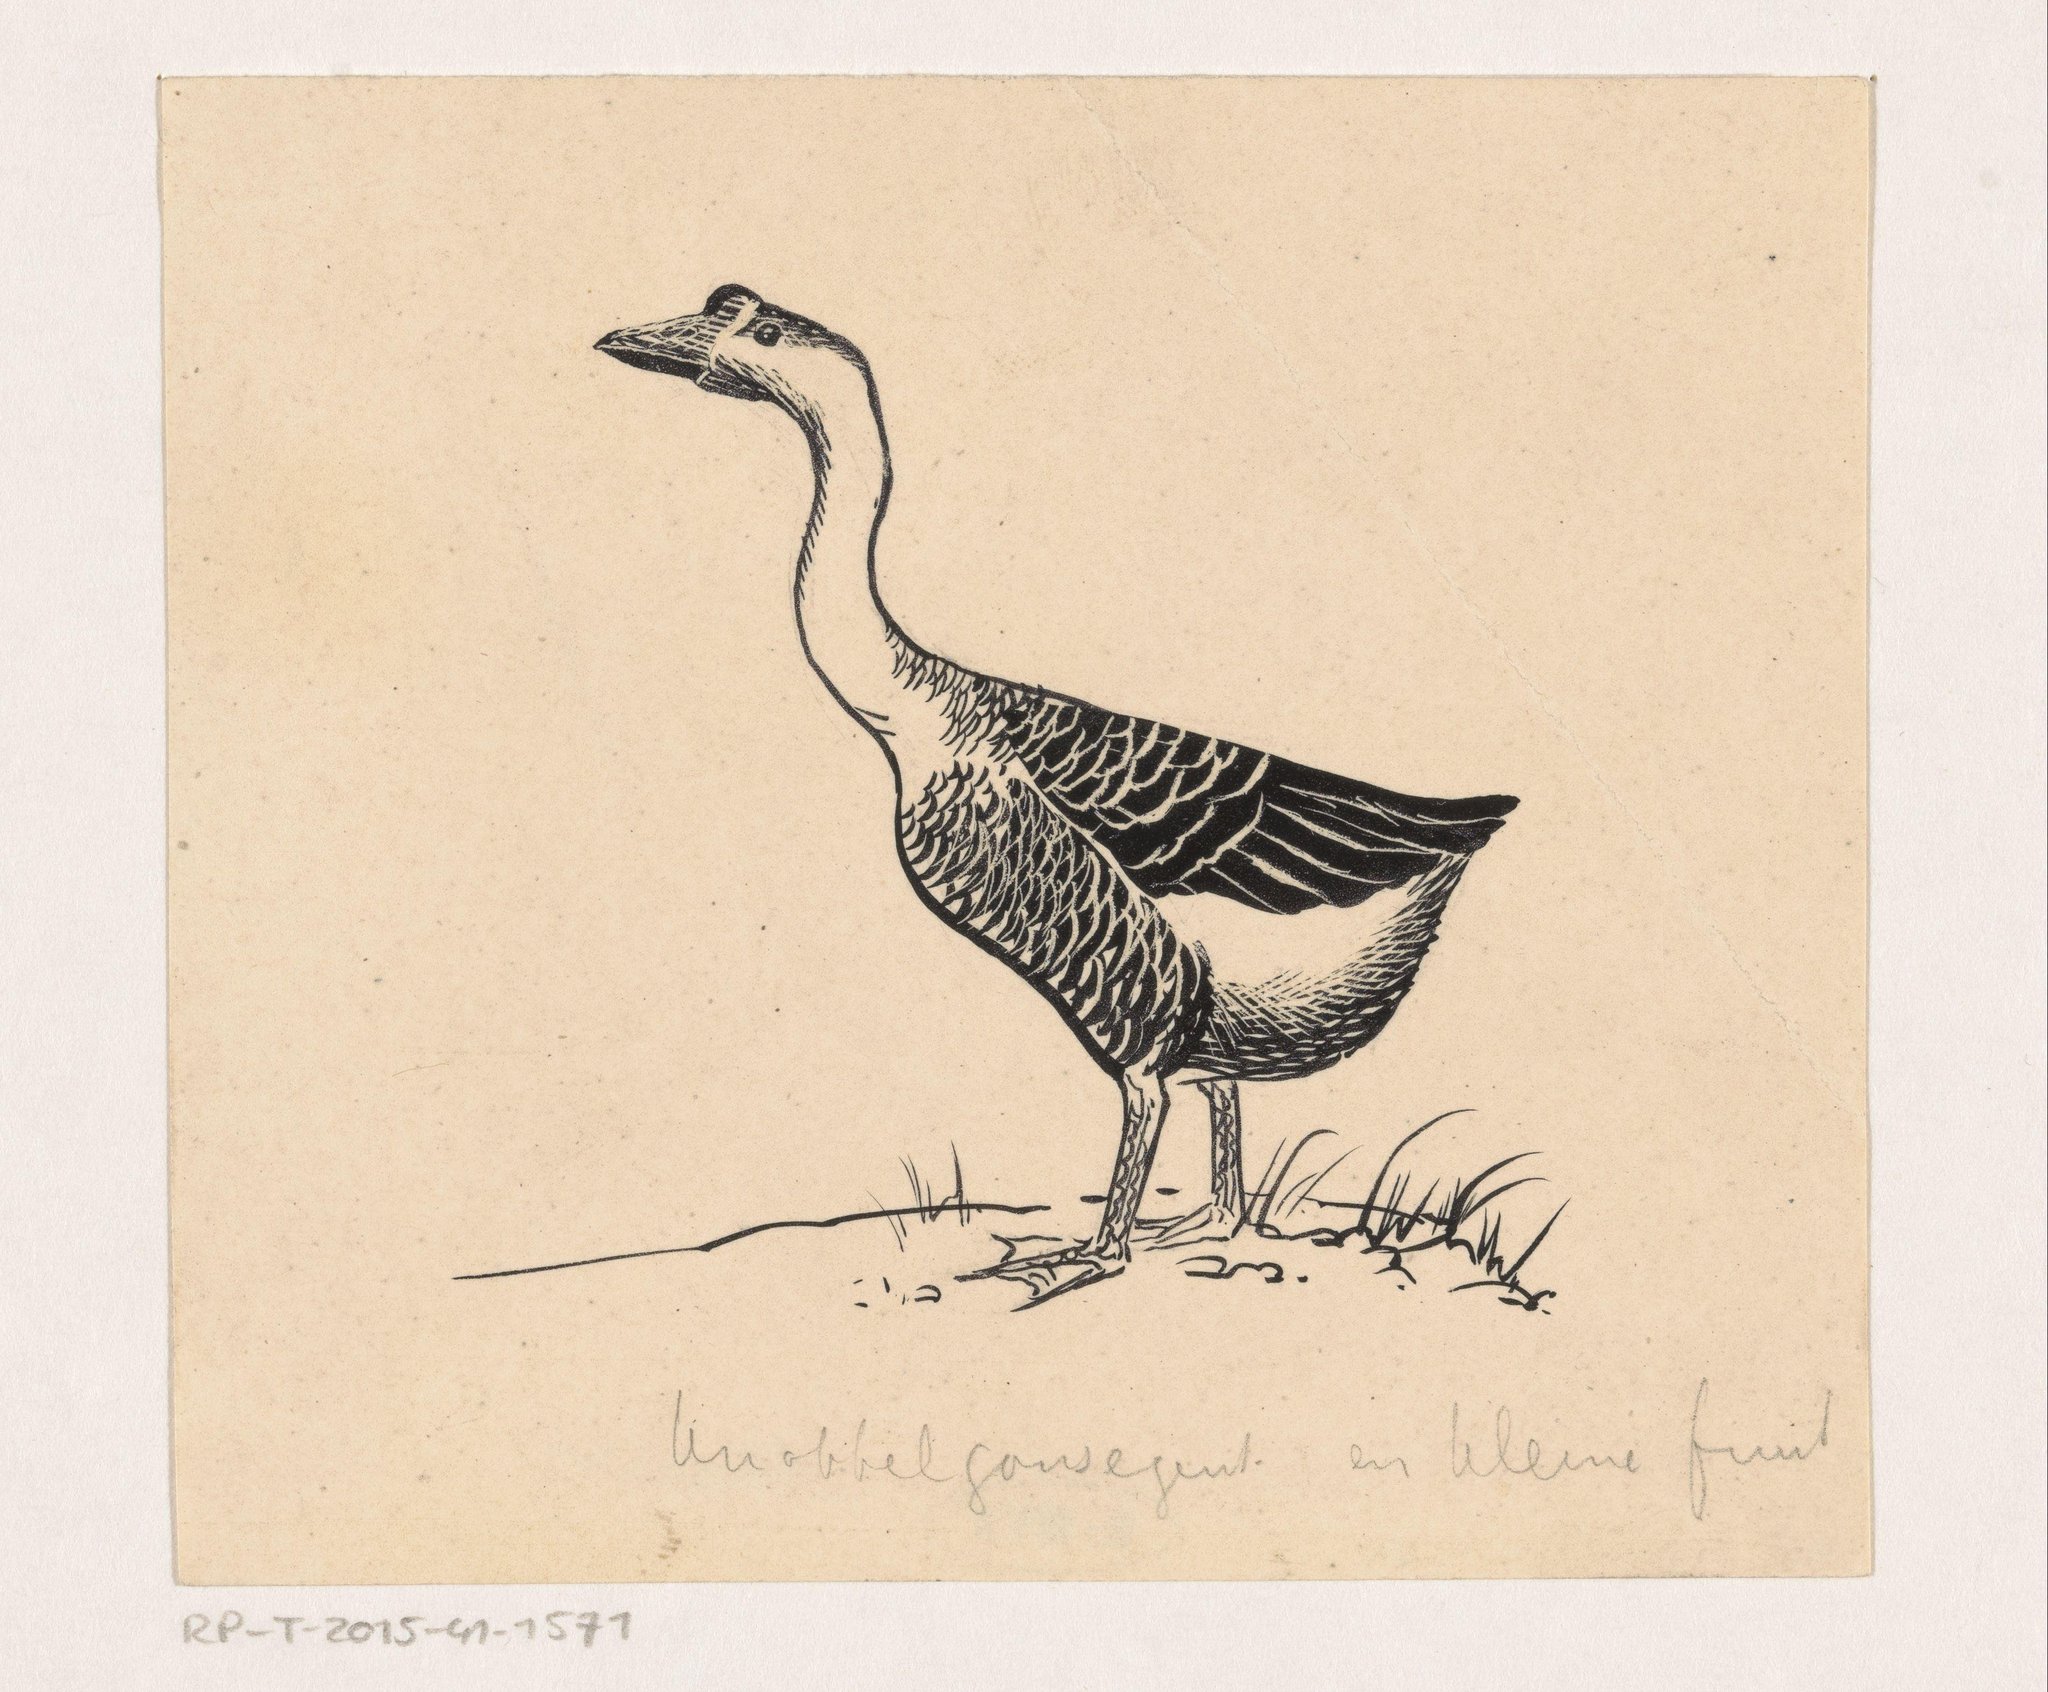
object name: boekillustratie ontwerp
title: Knobbelgans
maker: henri verstijnen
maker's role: draughtsman, print maker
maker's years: 1882-1940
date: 1892-1940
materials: ink, paper, pencil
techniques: pen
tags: water-birds: goose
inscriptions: :, annotation: ‘Weelde’, collector's mark: Lugt 2228, annotation: ‘knobbeldanse[...] en kleine fuut’